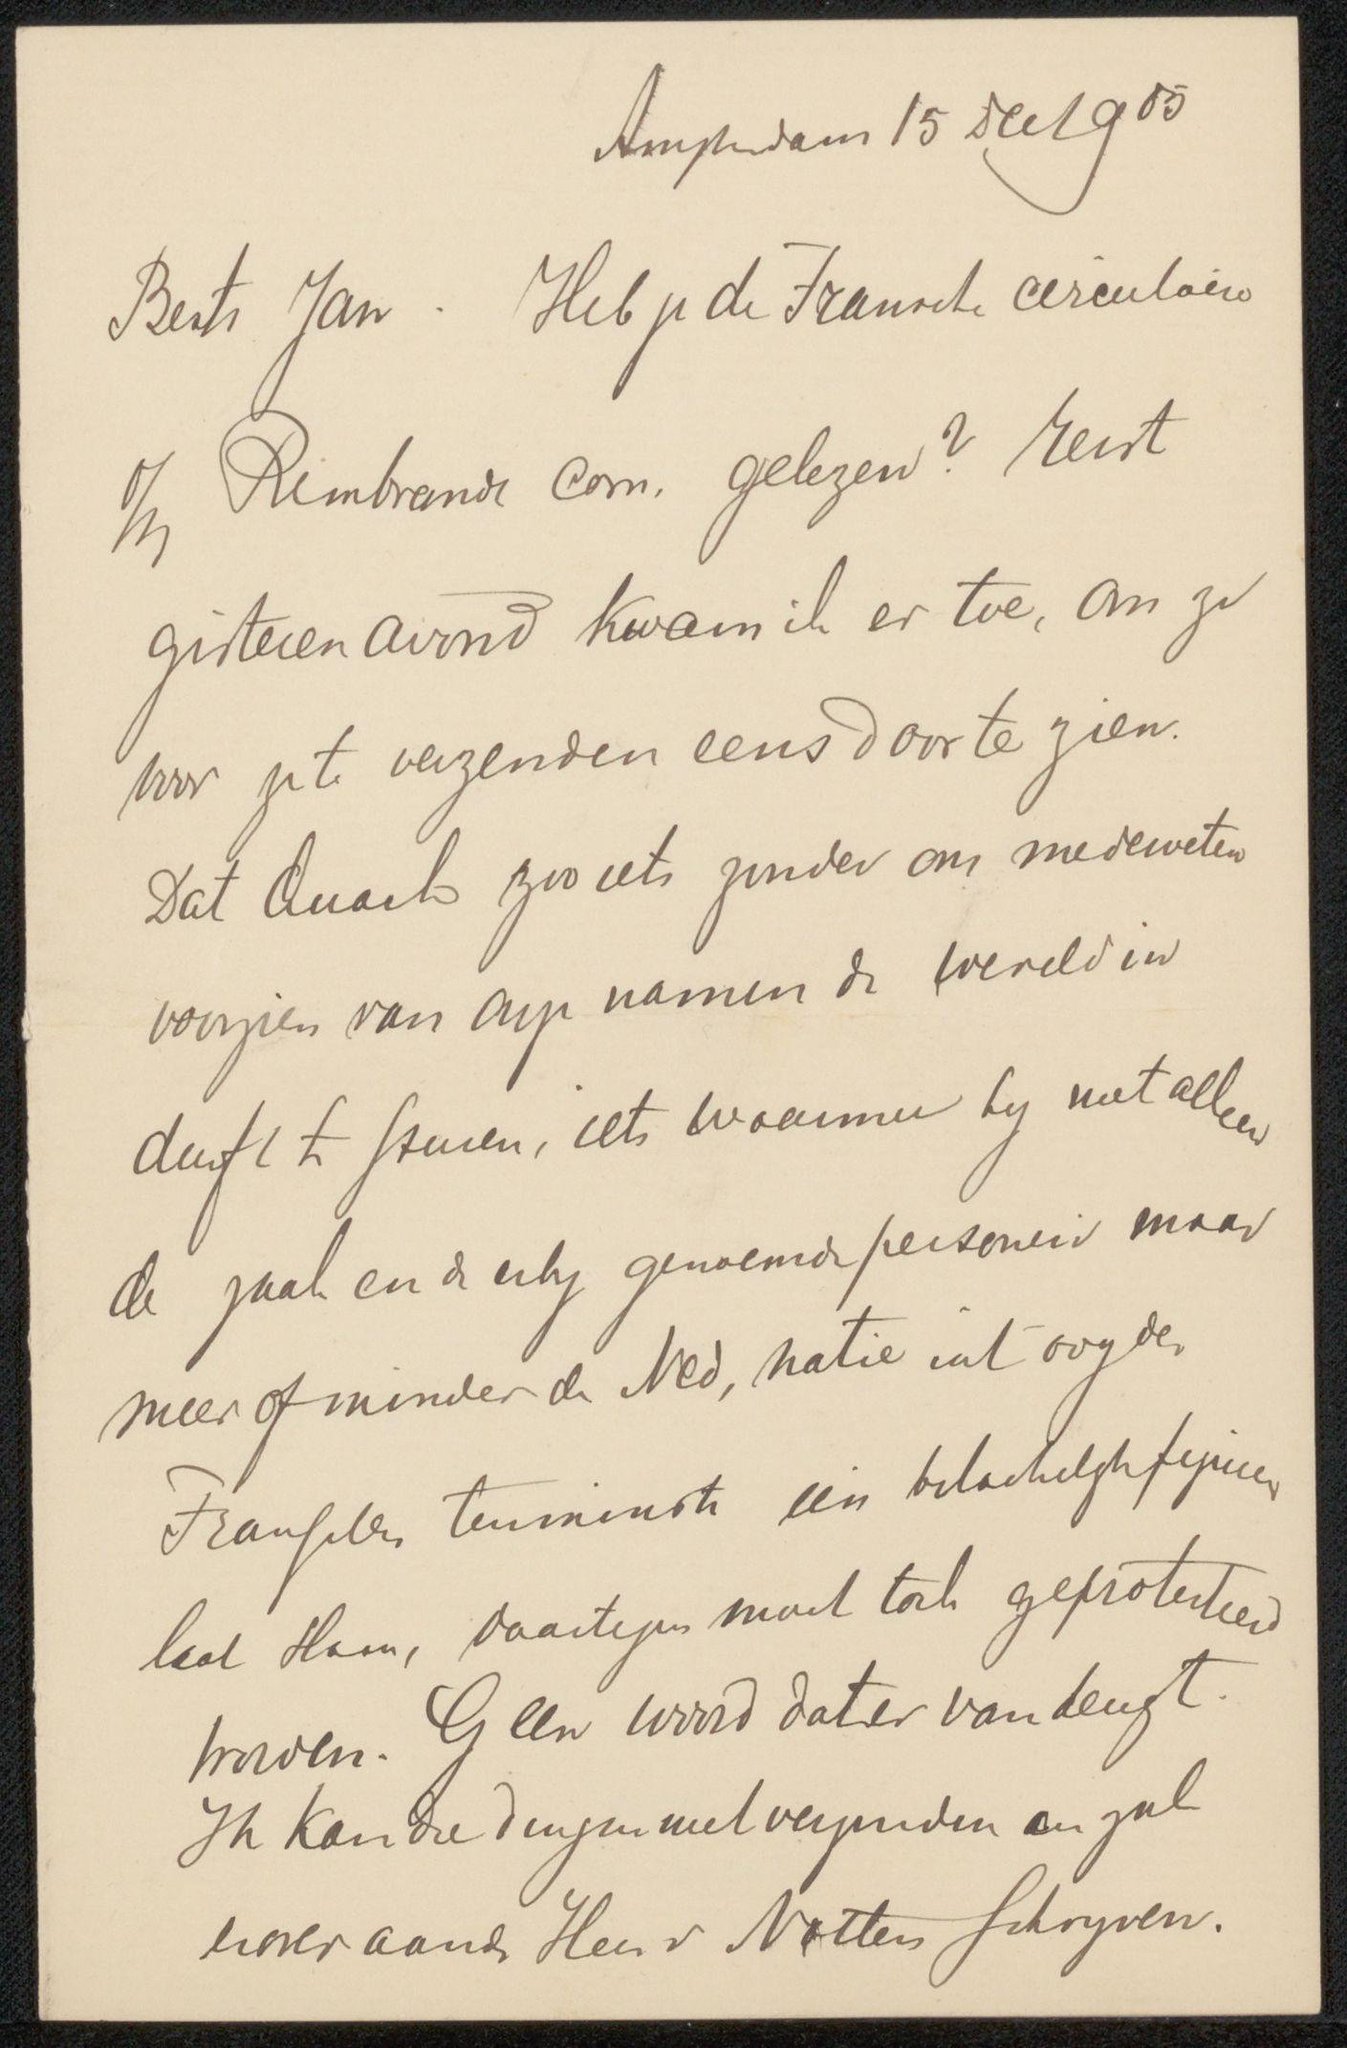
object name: letter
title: Brief aan Jan Veth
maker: alphons diepenbrock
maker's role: componist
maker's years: 1862-1921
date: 1905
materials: ink, paper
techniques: pen, writing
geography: amsterdam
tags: dordrecht, painter, print maker, draughtsman, designer, jan veth, leiden, rembrandt van rijn, lodewijk van deyssel, printed matter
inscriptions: collector's mark: ‘RPK’